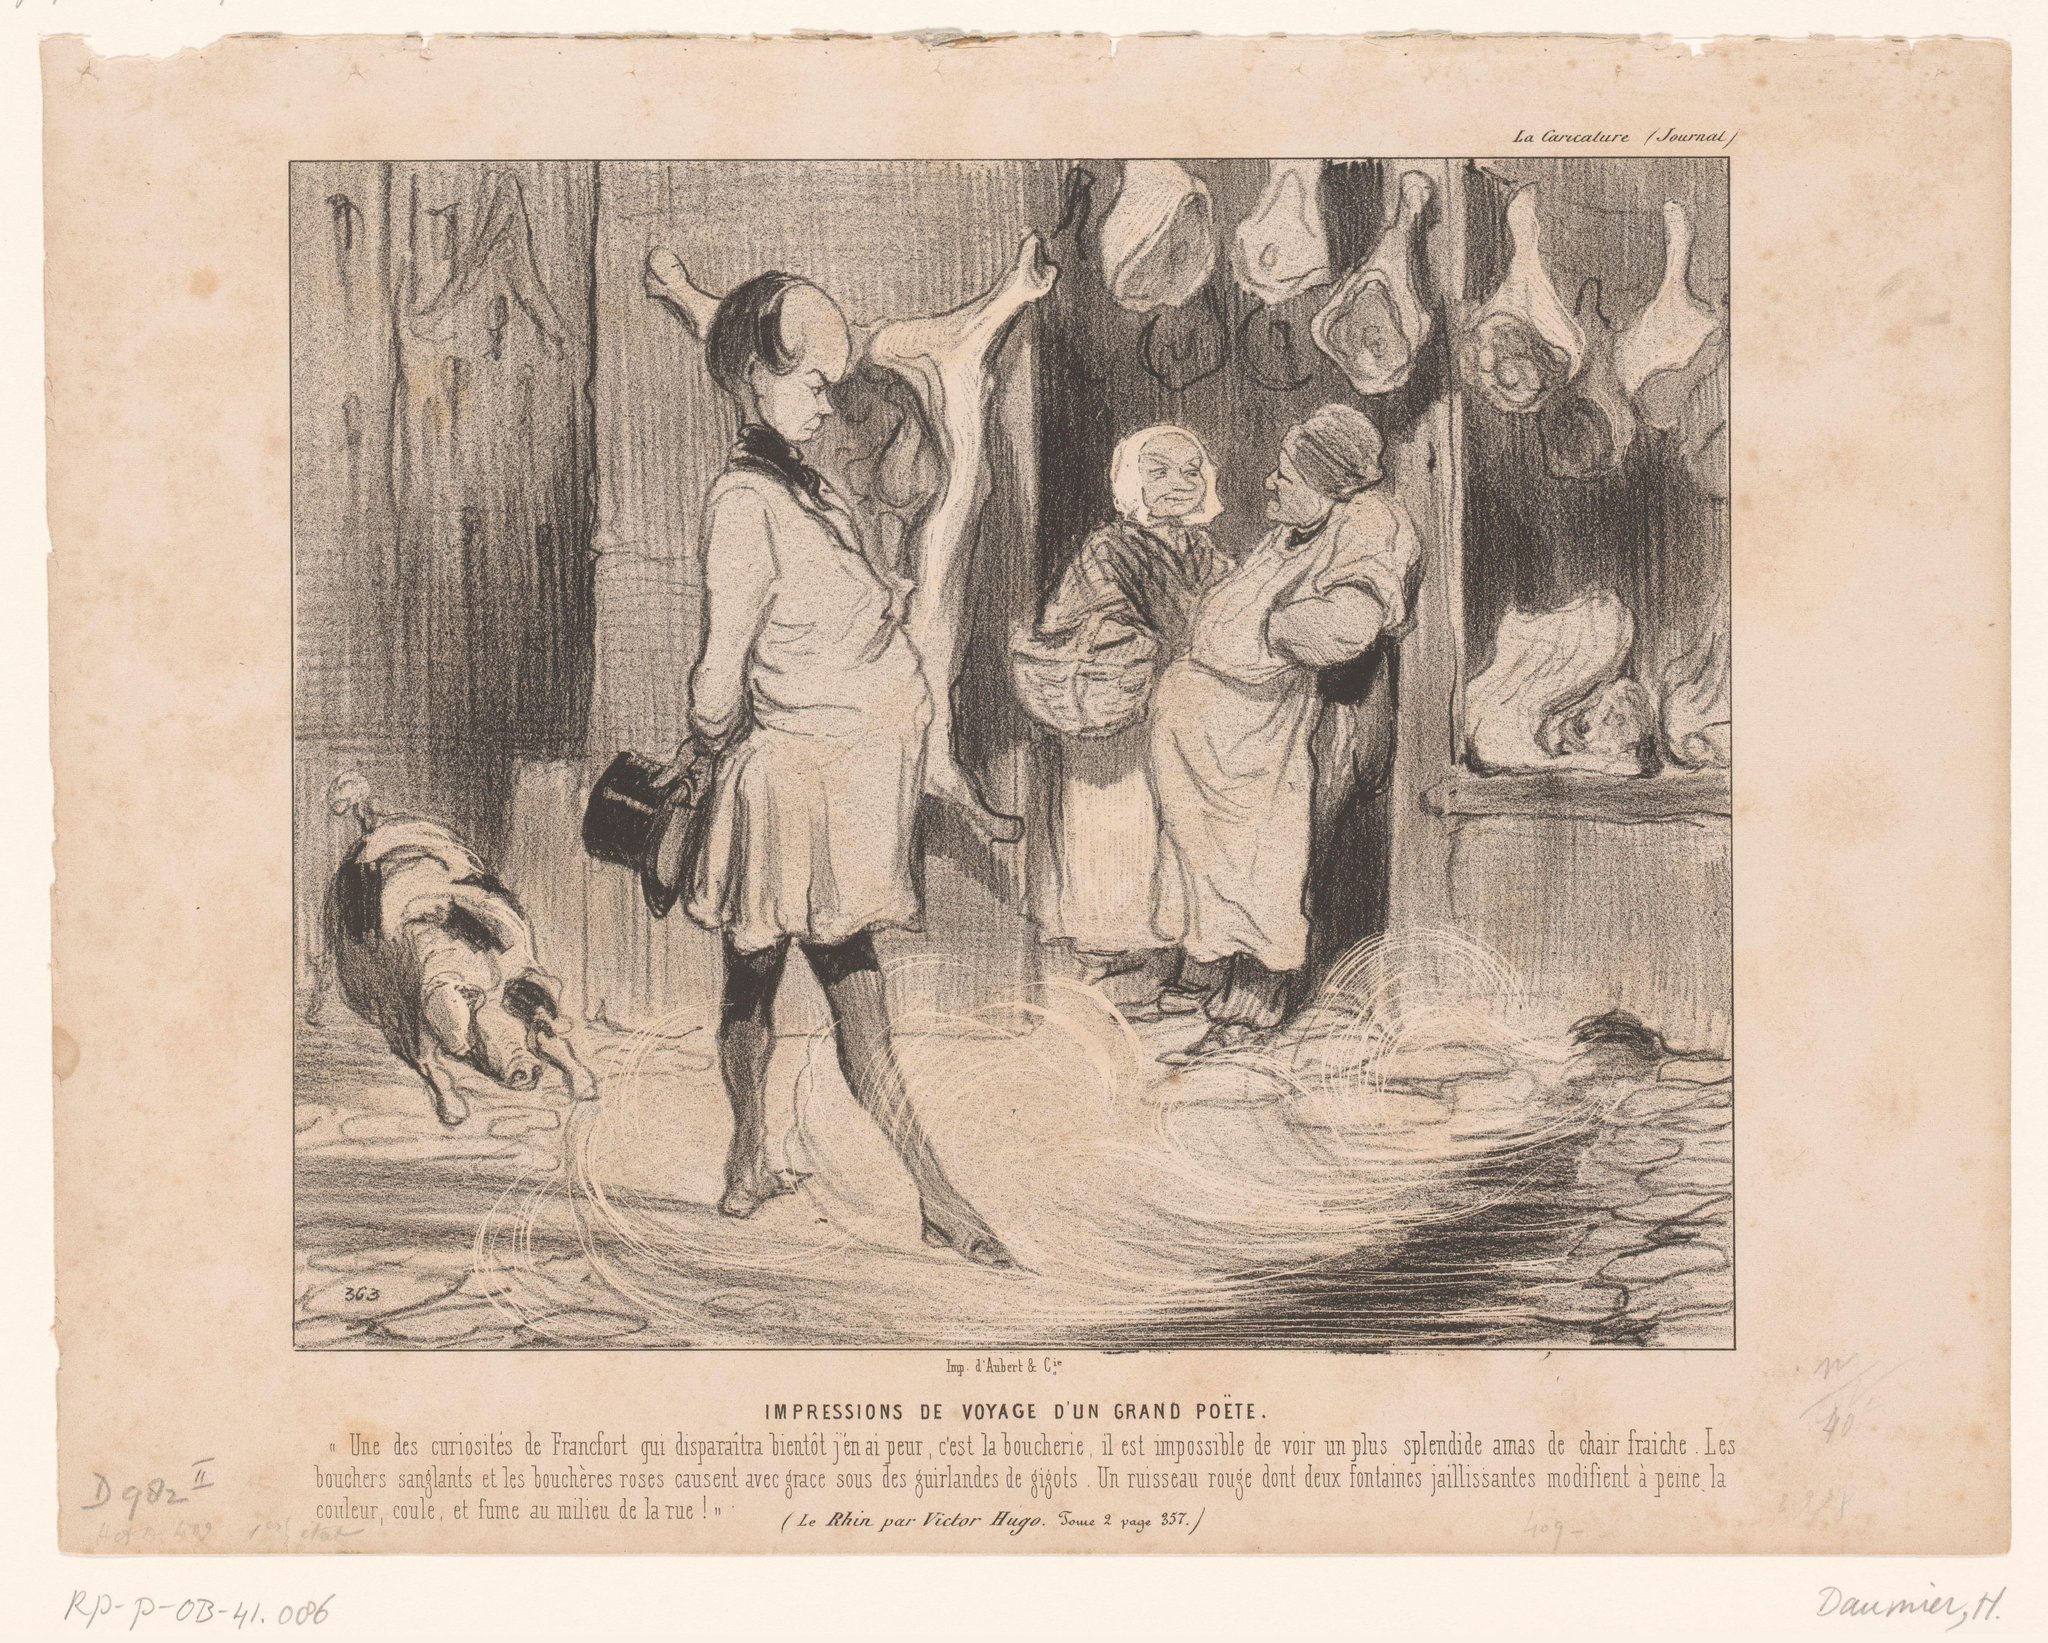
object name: cartoon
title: Karikaturen van het alledaagse leven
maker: honoré daumier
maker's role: draughtsman, painter, print maker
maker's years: 1808-1879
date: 1842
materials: paper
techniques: lithograph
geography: paris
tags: paris, victor hugo, caricatures (human types), historical persons, butcher, slaughterman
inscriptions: collector's mark: Lugt 2228a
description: Victor Hugo vindt de slagerijen in Frankfurt een bloederige curiositeit.